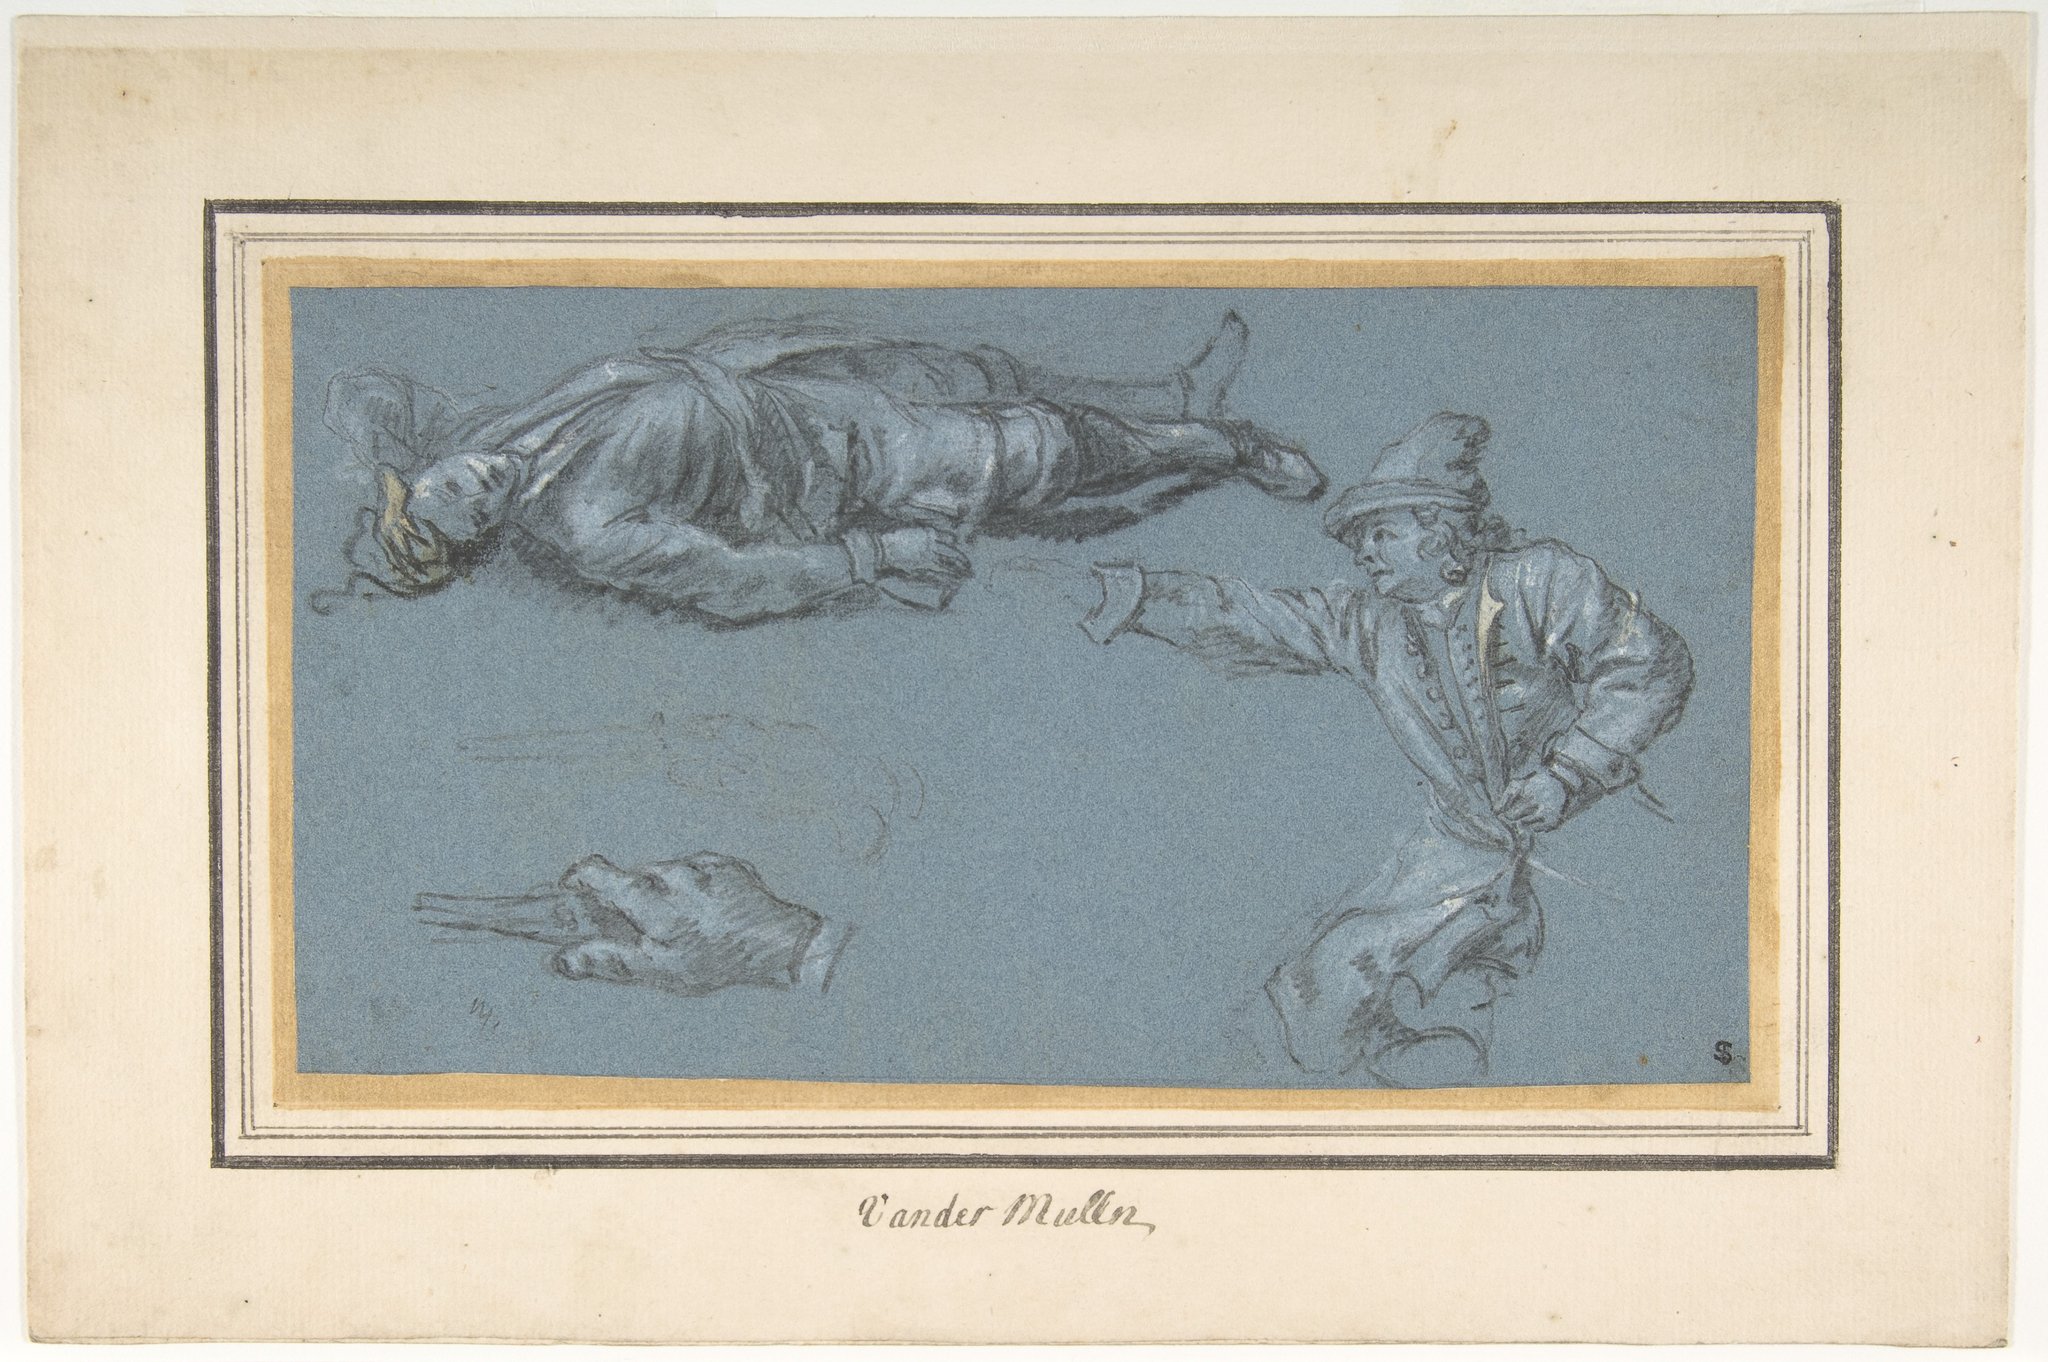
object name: drawing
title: Study of Two Soldiers and a Hand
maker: adam frans van der meulen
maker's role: artist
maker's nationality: flemish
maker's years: 1632-1690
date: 1601-1700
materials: chalk, gouache, paper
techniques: heightening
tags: soldiers,hands,men